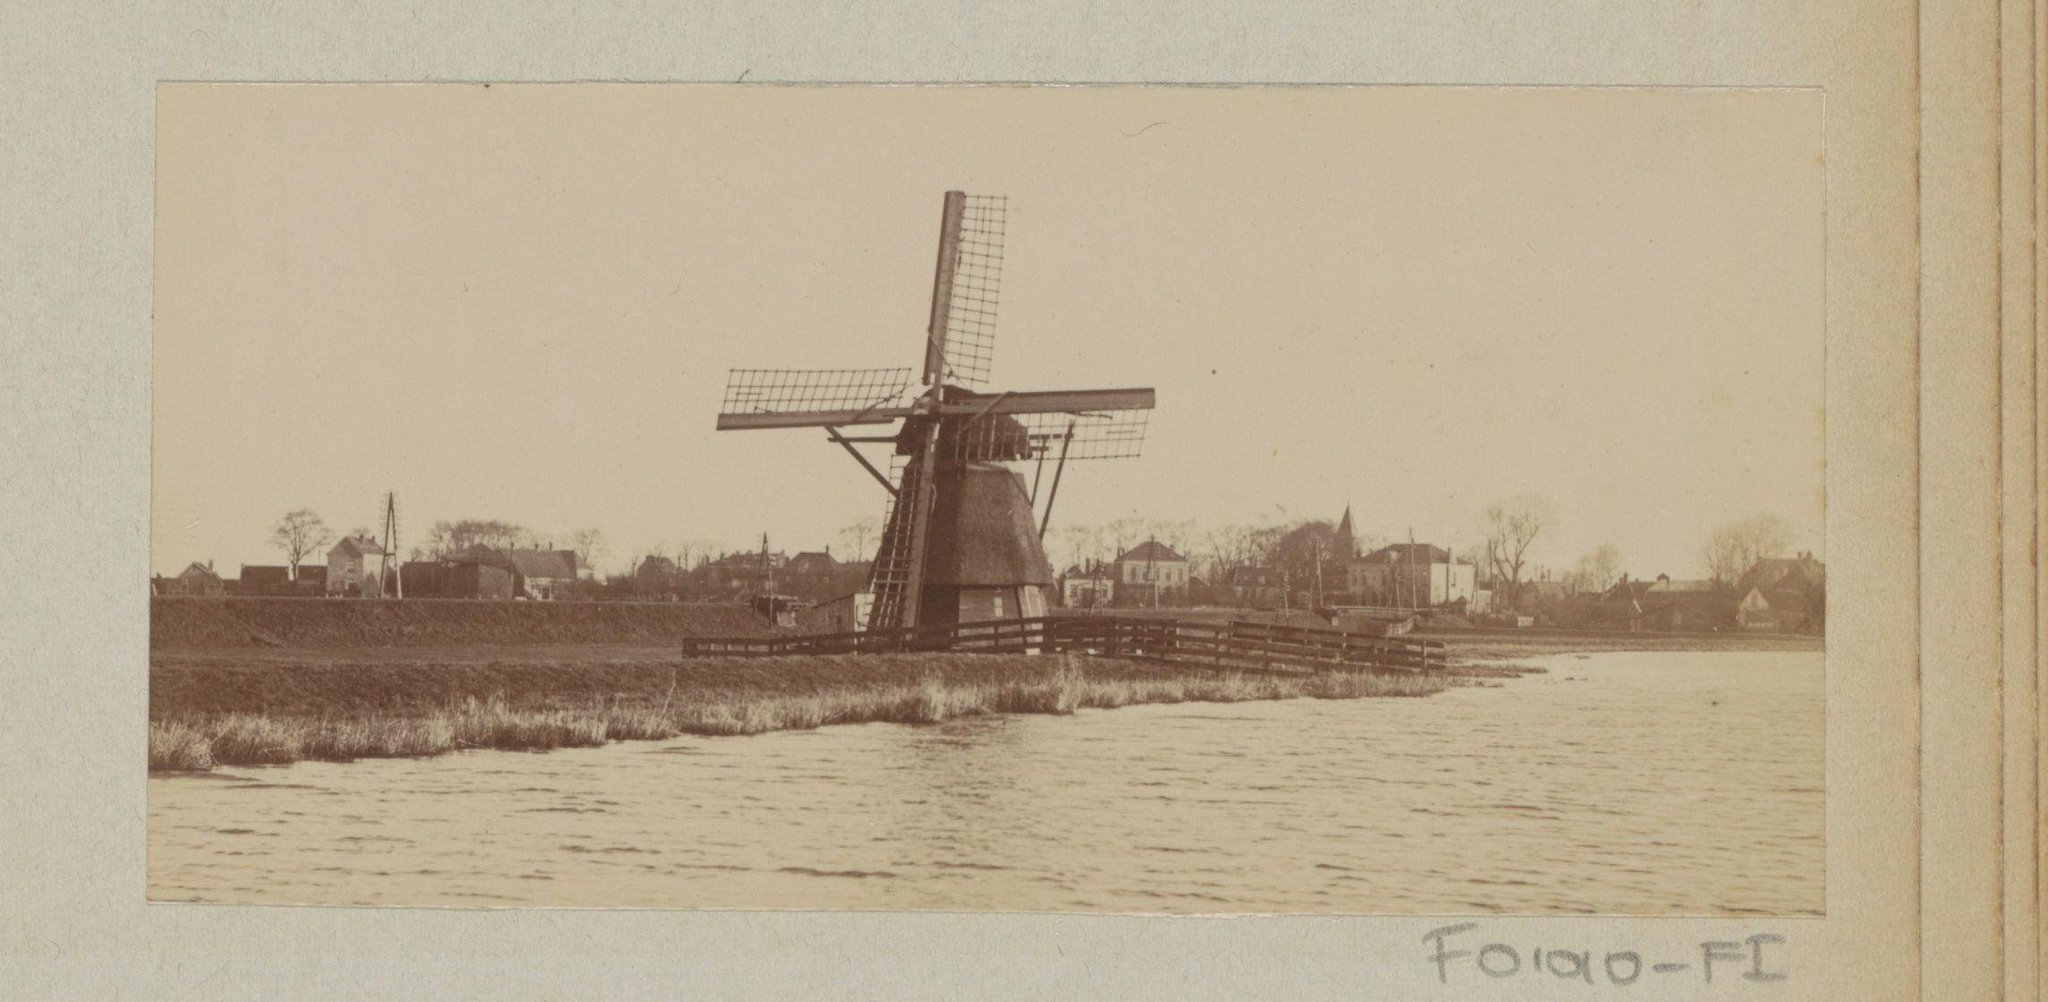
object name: photograph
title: Windmolen, vanaf het water gezien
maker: Anonymous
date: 1900-1910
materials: photographic support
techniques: daylight paper print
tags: windmill in landscape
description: Onderdeel van Familiealbum met onder meer foto's van Wijnhandel Kraaij & Co. Bordeaux-Amsterdam.